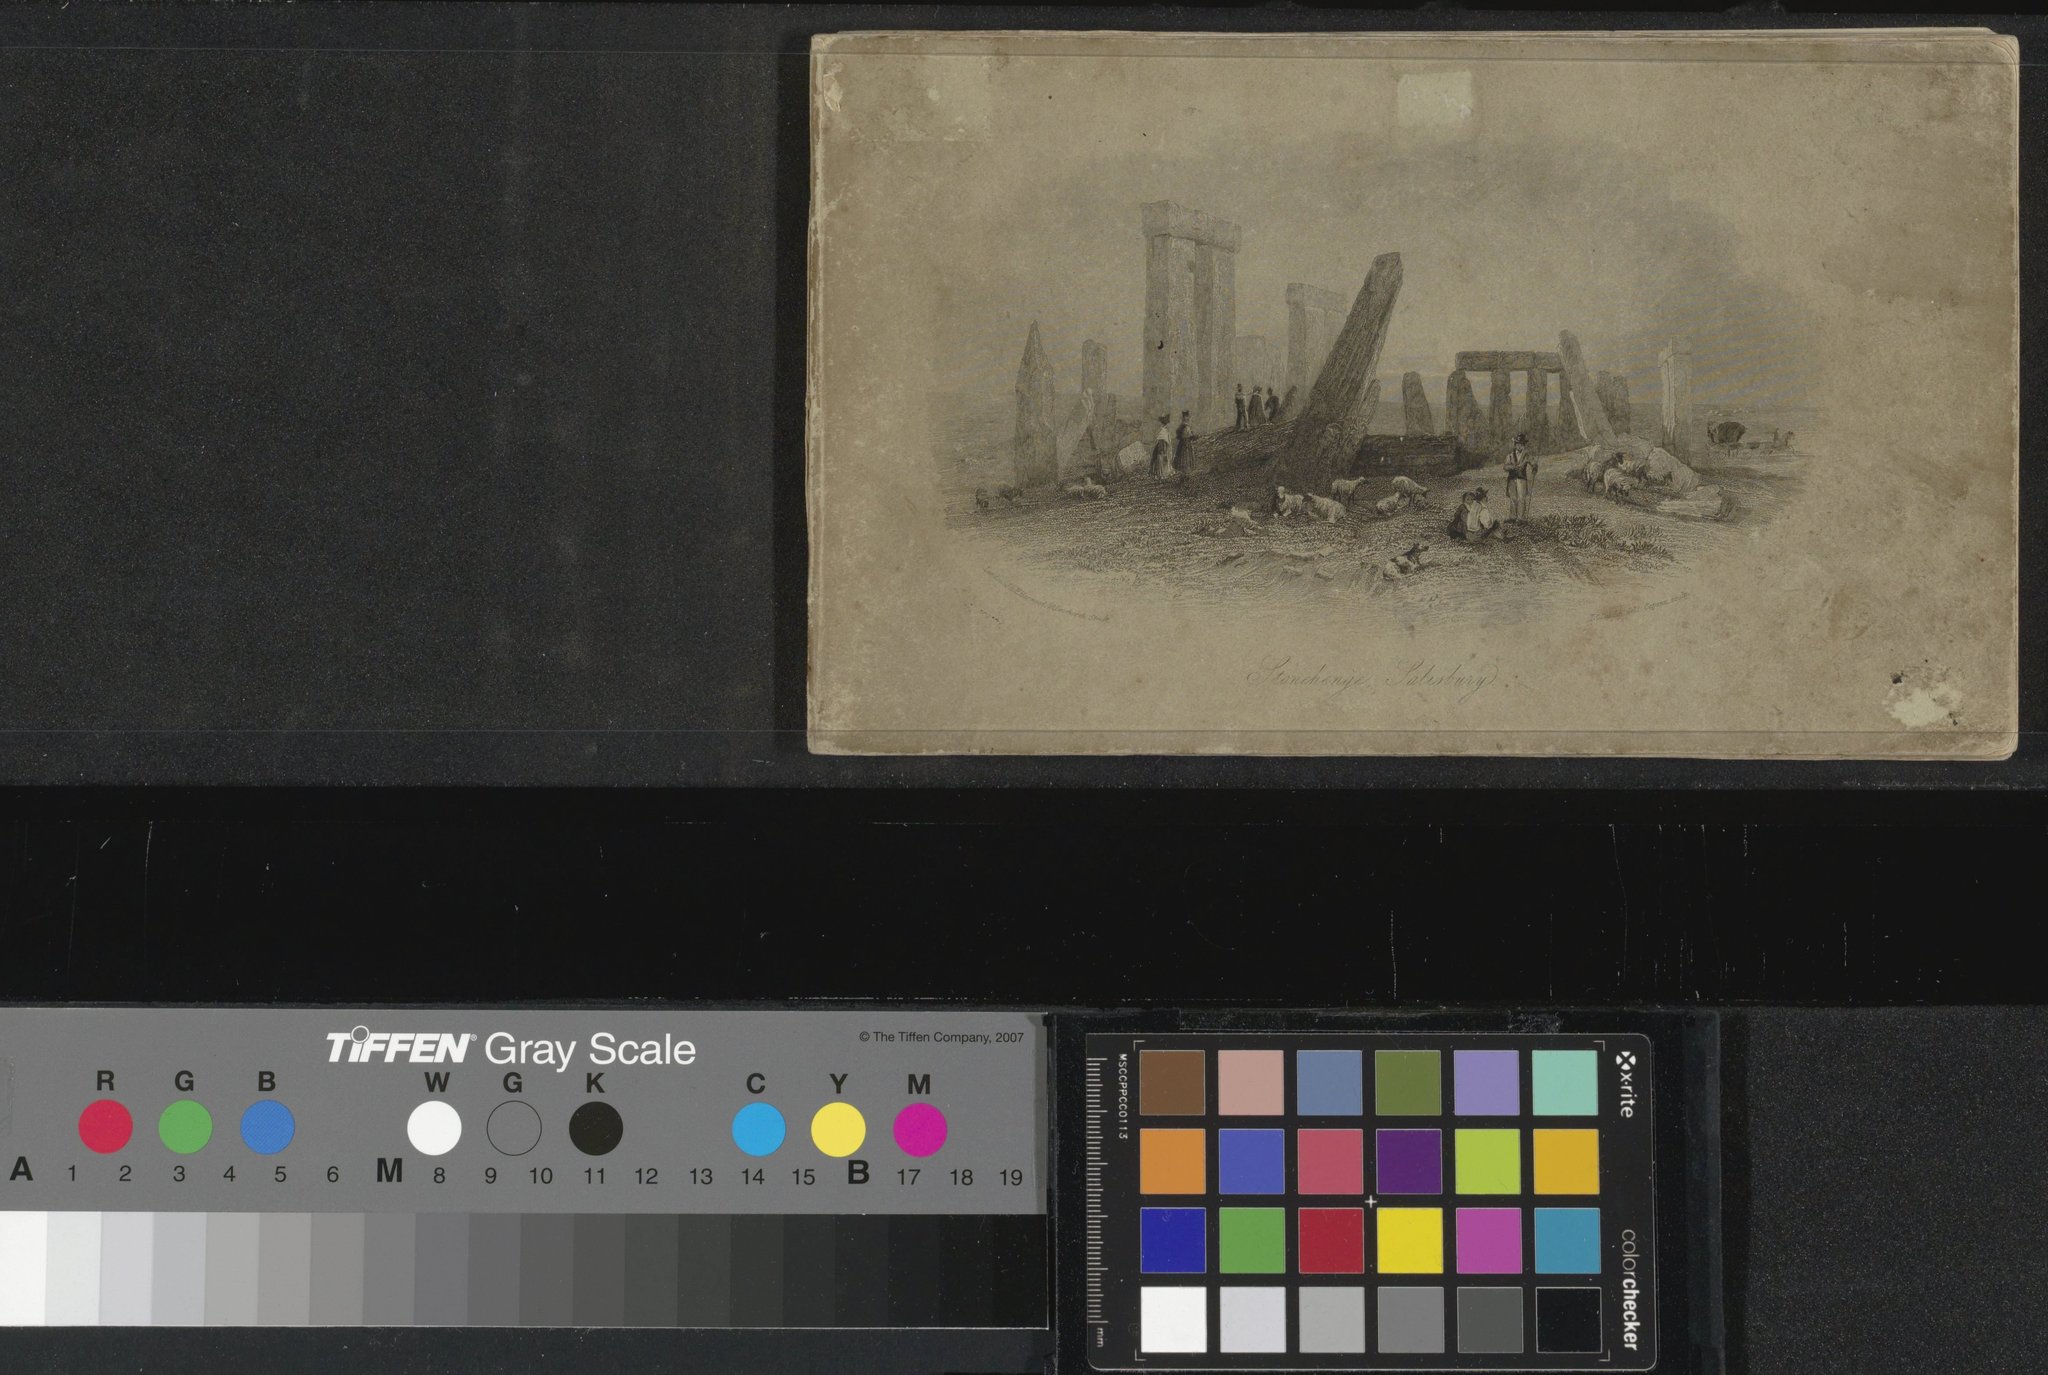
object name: sketchbook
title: Schetsboek met 80 pagina's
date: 1841-1865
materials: cardboard, paper, pencil, watercolor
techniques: brush, engraving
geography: england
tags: harbour, sailing-ship, sailing-boat, cave, grotto, coast, prospect of city, town panorama, silhouette of city, enkhuizen, amsterdam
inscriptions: annotation: ‘...’, collector's mark: Lugt 2228a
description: Schetsboek uitgegeven door de firma J. & E. Harwood te Fenchurch Street 26 in London met op de voorzijde van de omslag een prent van Stonehenge te Salisbury en aan de achterzijde van de omslag een prent van een landschap met figuren te Winchester. De volgende pagina's uit het schetsboek zijn blanco: 2, 4, 6, 8, 10, 12, 14, 16, 20, 22, 24, 25 t/m 27, 31 t/m 33, 38, 56, 60, 62, 64, 68, 70, 73, 77 en 79.